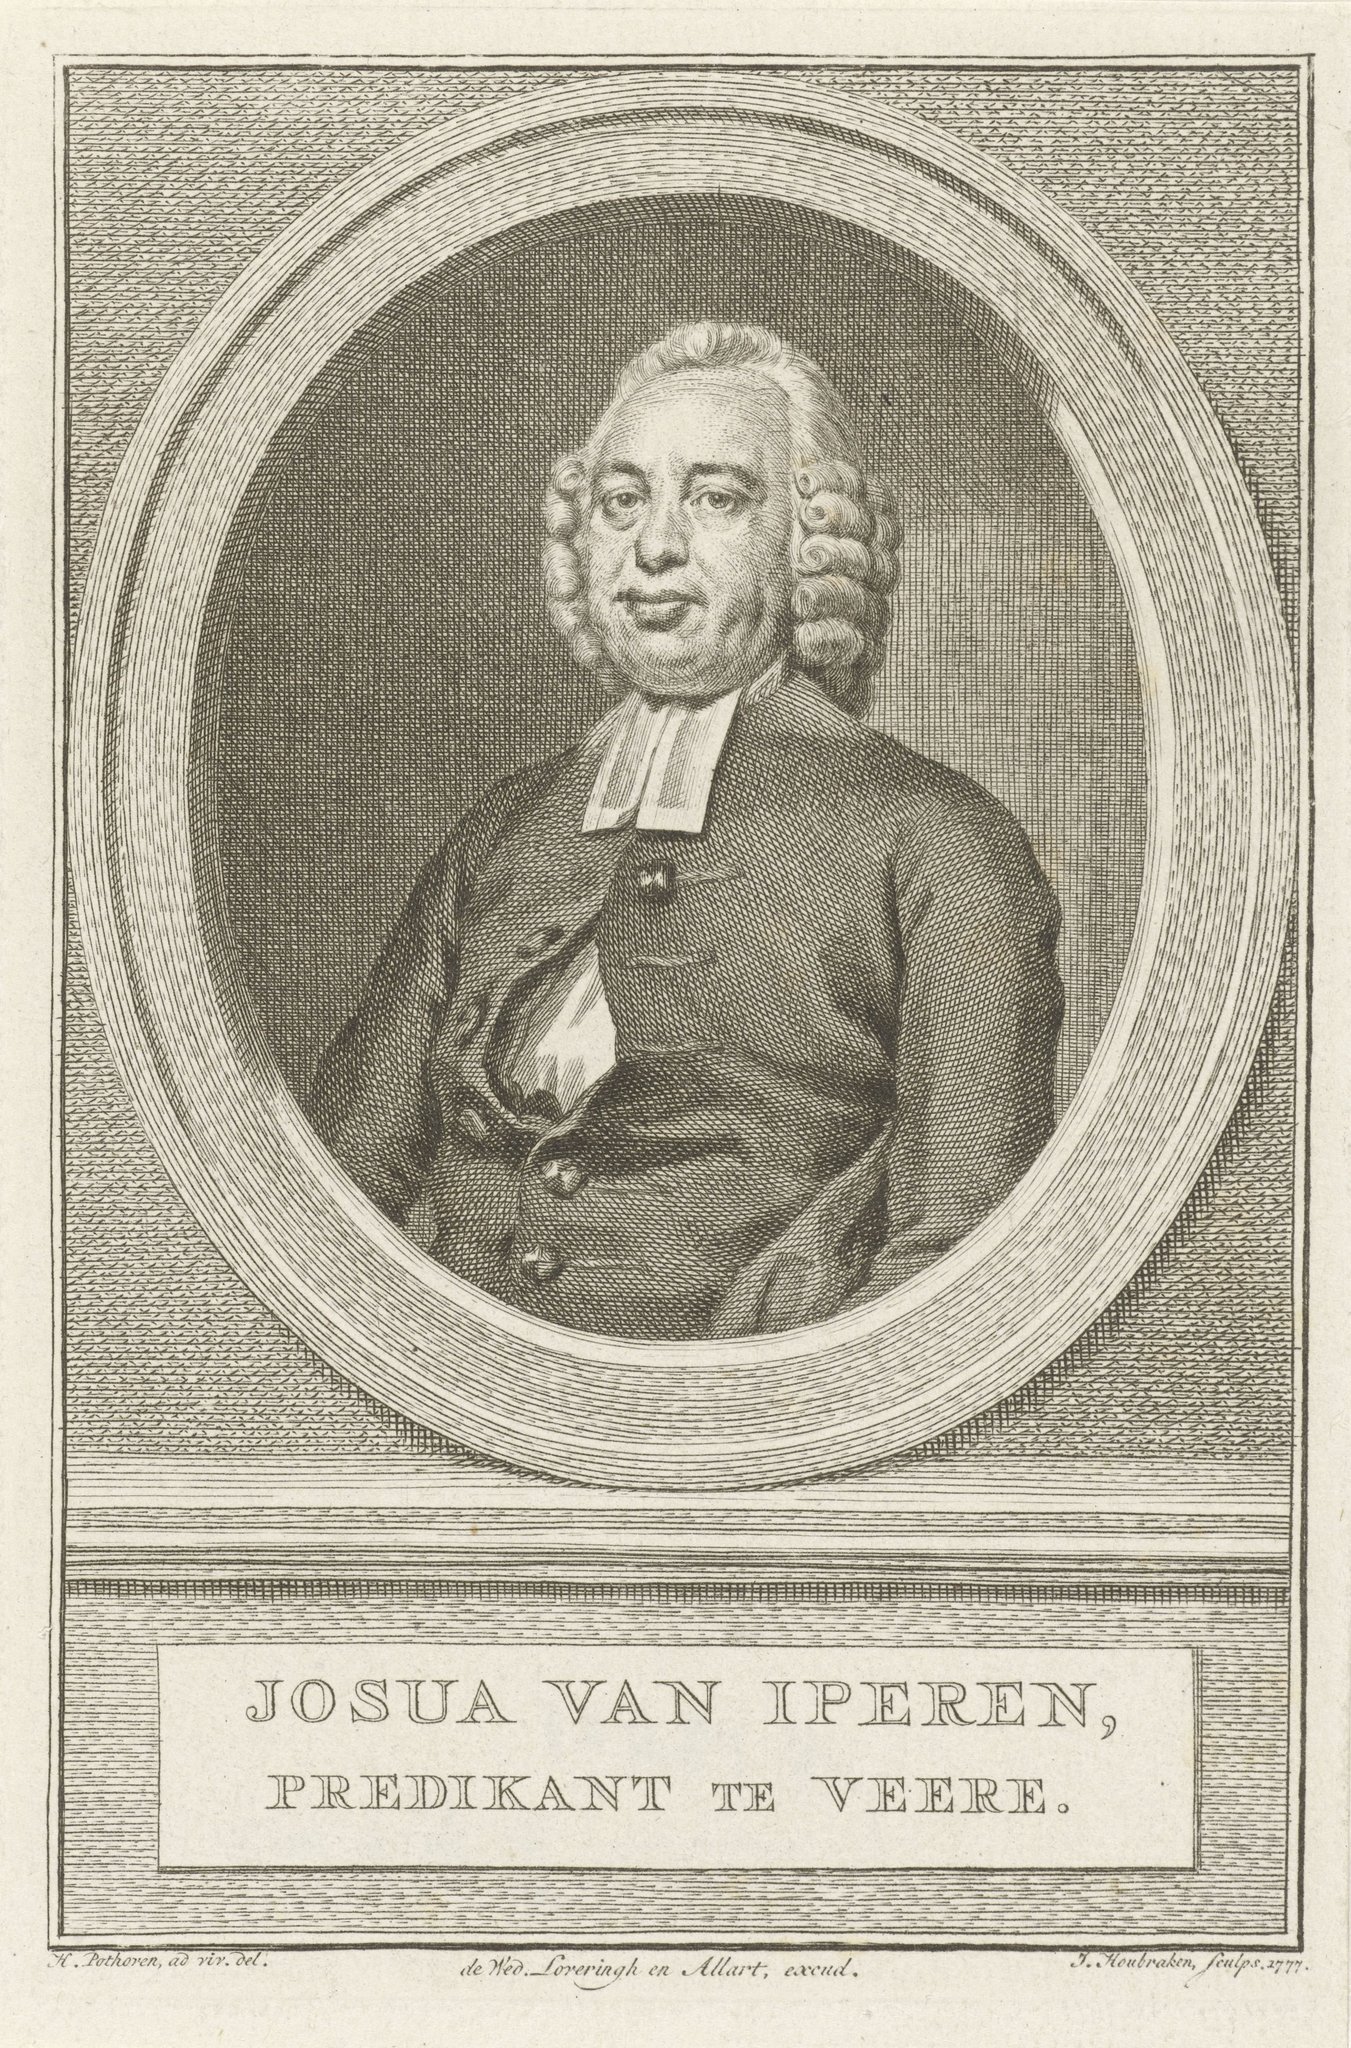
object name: print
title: Portret van Josua van Iperen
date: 1777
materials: paper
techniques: engraving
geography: amsterdam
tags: middelburg, batavia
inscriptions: collector's mark: Lugt 2228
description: Prent volgens Ver Huell ook gebruikt in: Josua van Iperen, Kerkelyke historie van het psalm-gezang der christenen (...) en inzonderheid van onze verbeterde Nederduitsche psalmberyminge. Amsterdam: wed. Loveringh en Allart, 1777. Deel 2: J. Allart, 1778.